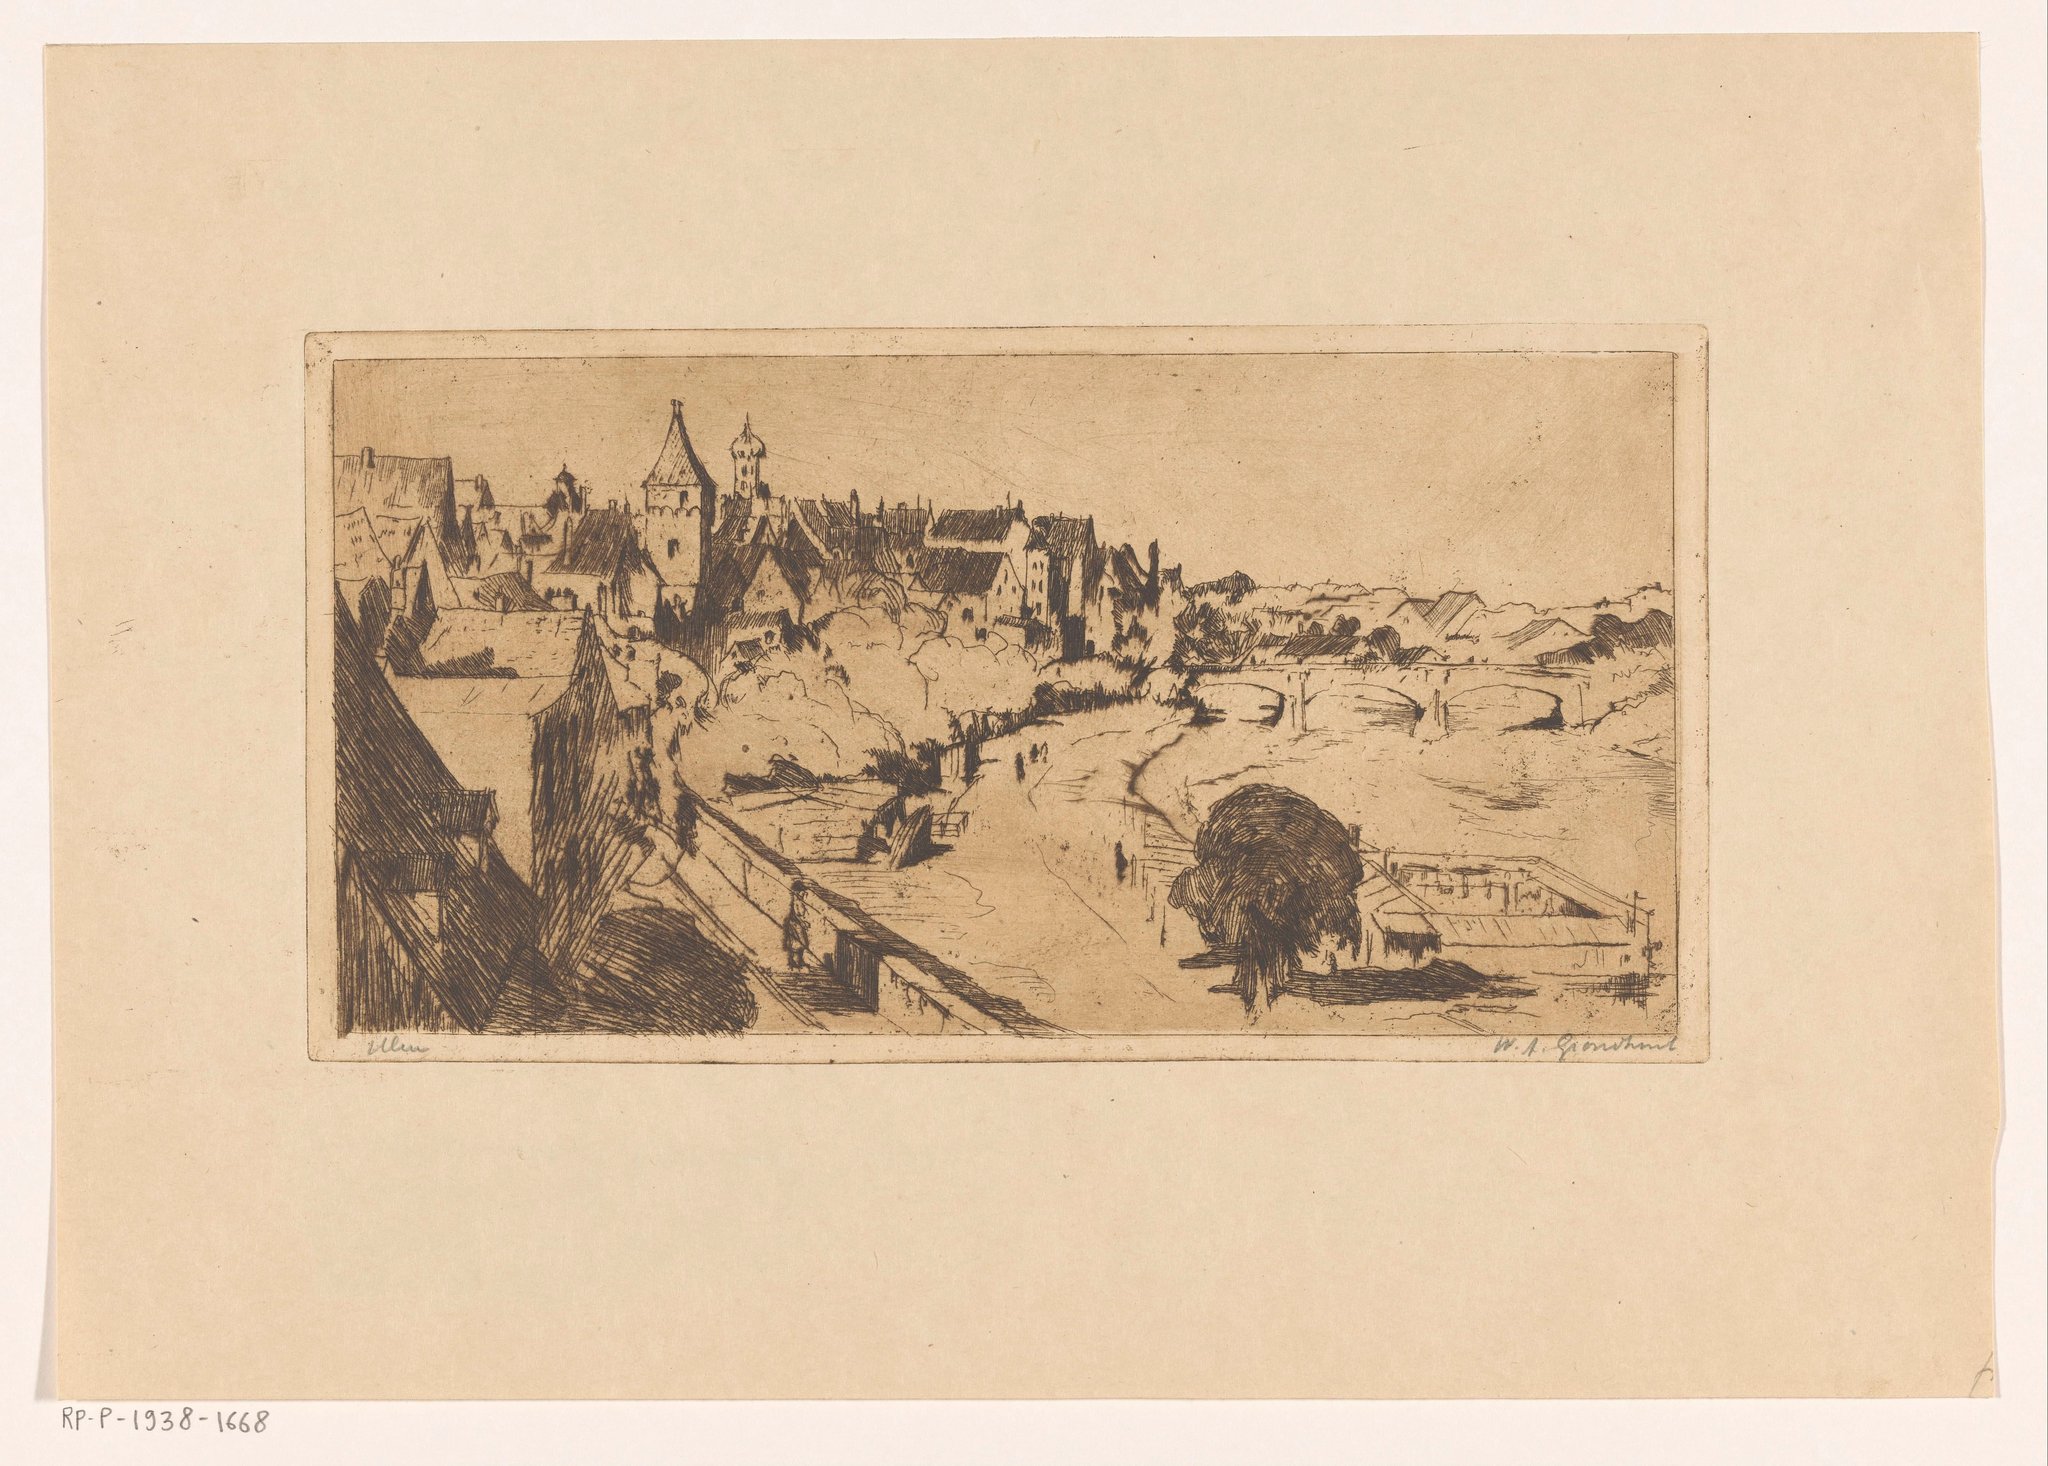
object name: print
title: Ulm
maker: willem adrianus grondhout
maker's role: draughtsman, painter, print maker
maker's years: 1878-1934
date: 1888-1934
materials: paper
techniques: etching, intaglio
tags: city-walls, bridge in city across river, canal, etc.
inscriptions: collector's mark: Lugt 2228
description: Een brug over de Donau in Ulm. Links van het midden een stadsmuur en de Metzgerturm, een stadspoort.